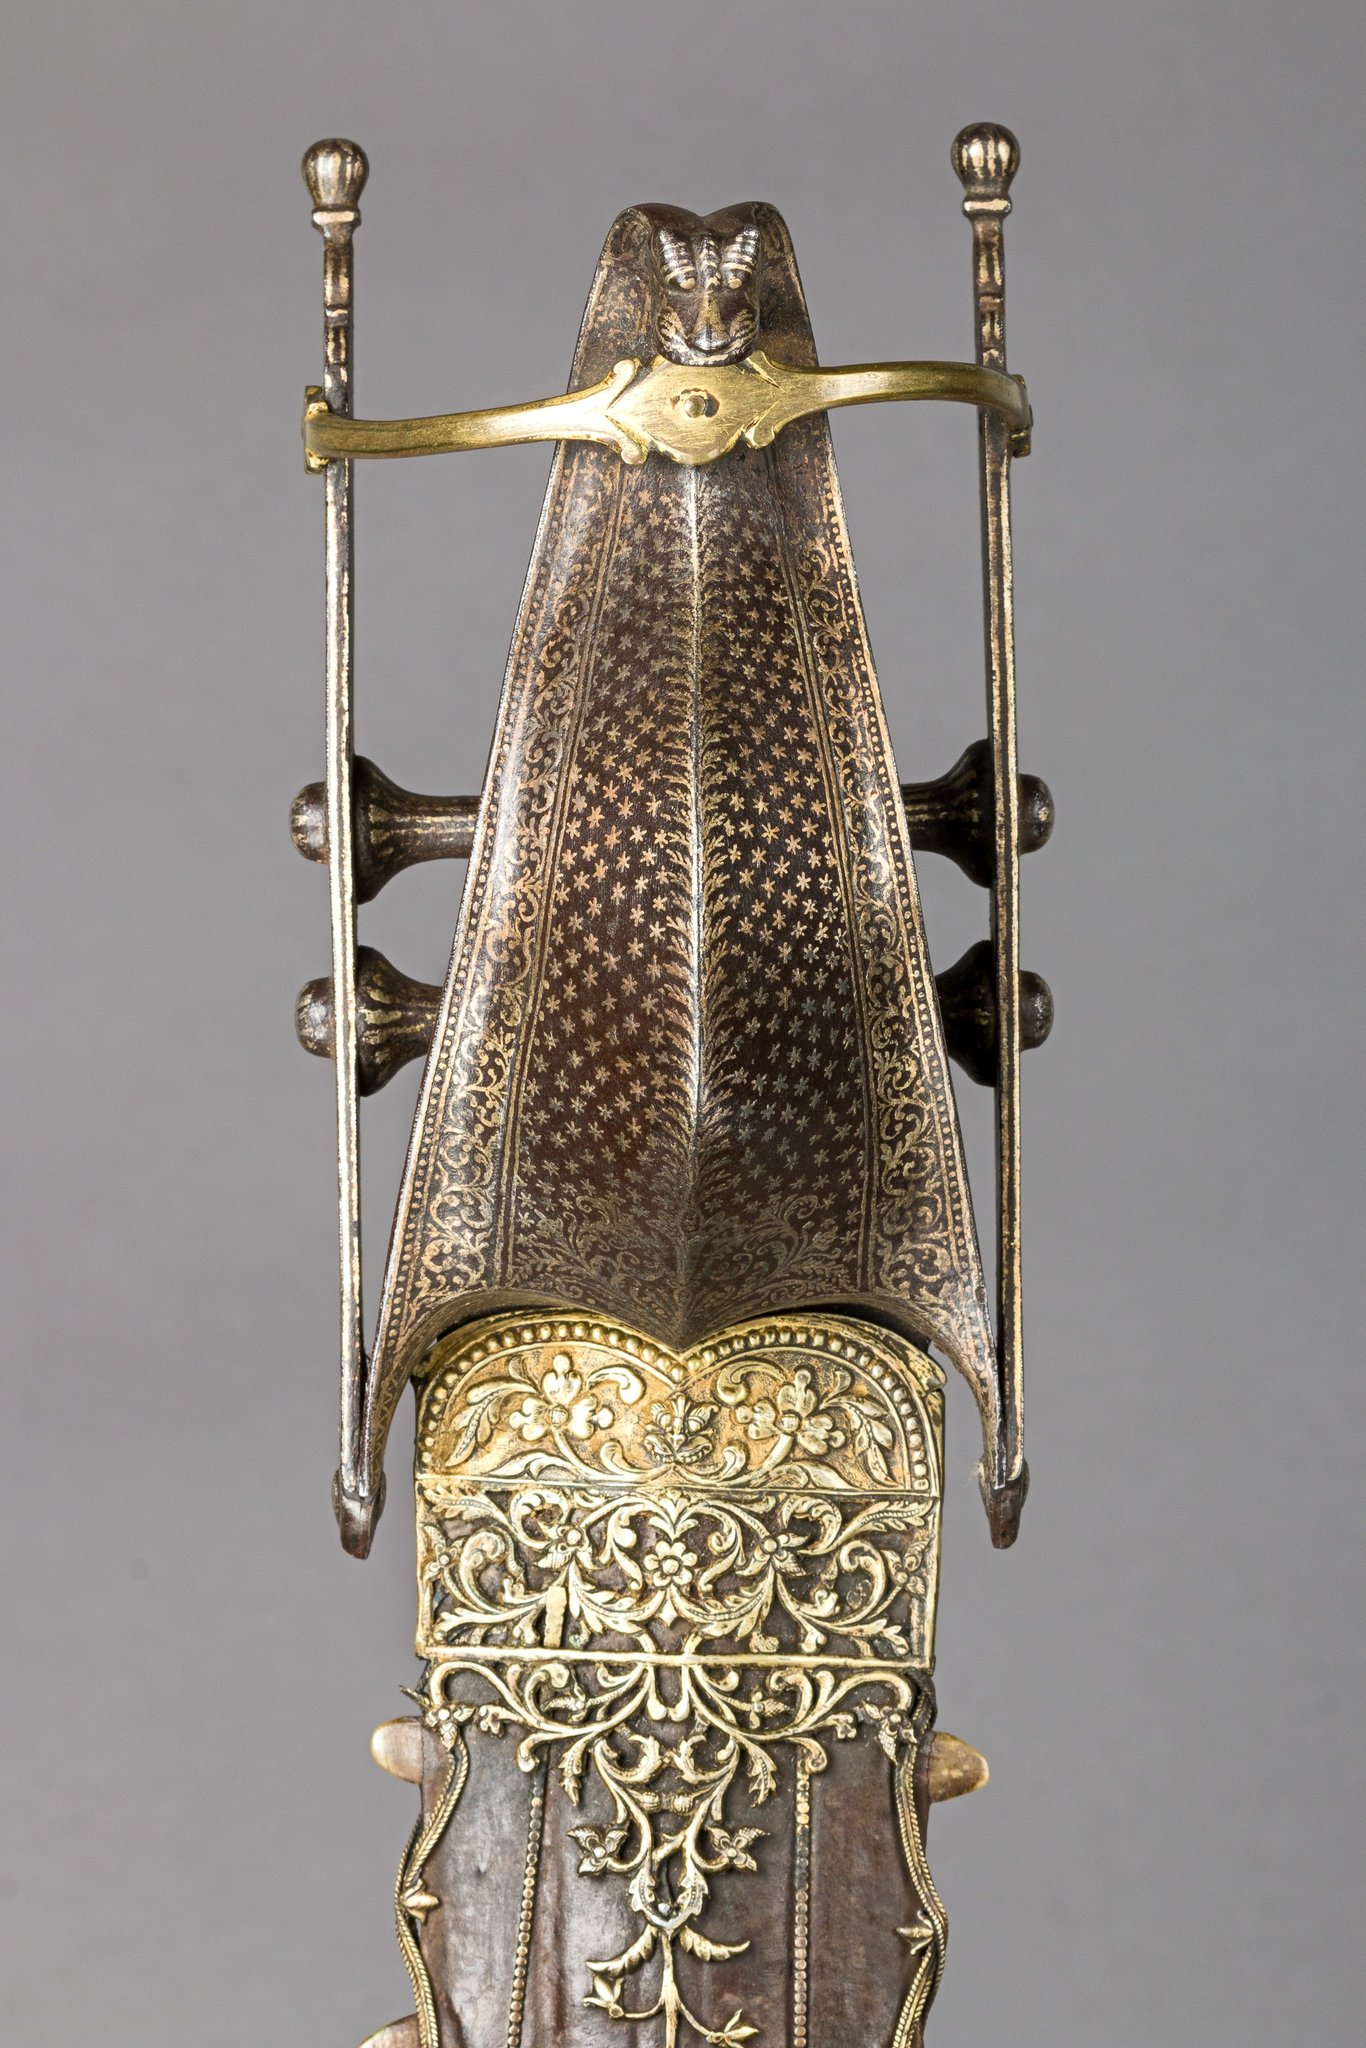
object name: dagger with sheath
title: Dagger (Katar) with Sheath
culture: indian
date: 1551-1600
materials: gold, leather, silver, steel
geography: south india